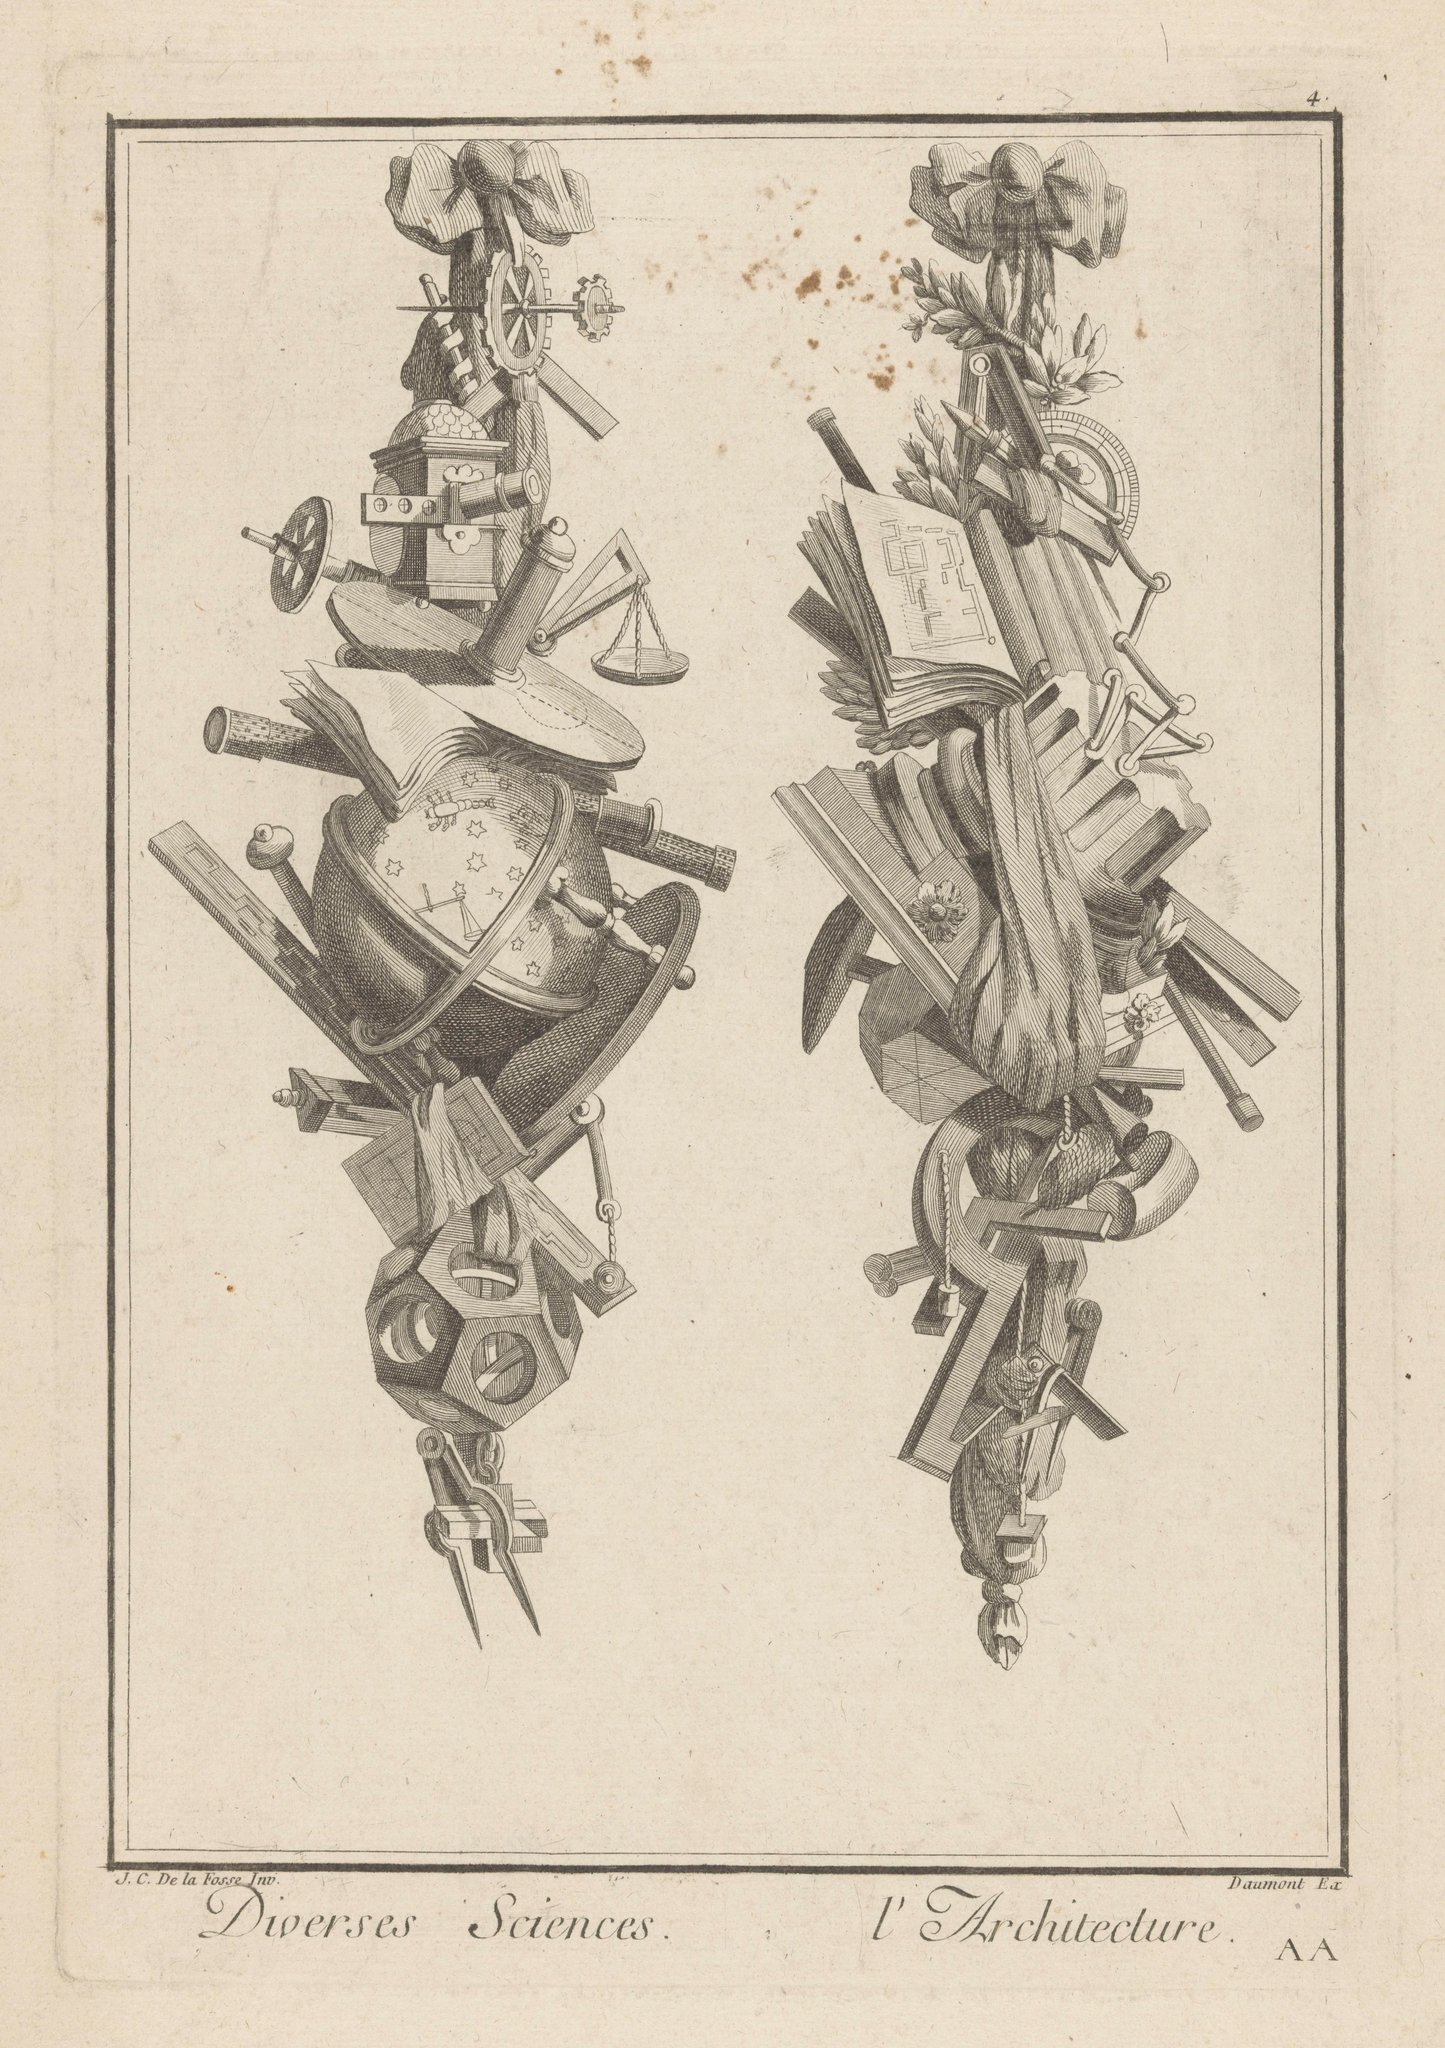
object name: ornament print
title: Diverses Sciences, l'Architecture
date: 1745-1755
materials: paper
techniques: engraving, etching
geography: paris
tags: trophy, i.e.: decorative arrangement of symbolic or typical objects ~ ornament, symbolic representations, allegories and emblems ~ science, 'scientia'; 'scienza', 'studio' (ripa), 'architectura', symbolic representations, allegories and emblems ~ architecture; 'architettura' (ripa)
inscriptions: collector's mark: Lugt 2760, collector's mark: Lugt 2228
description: Links een trofee met attributen behorende bij diverse wetenschappen zoals een globe, telescopen en meetinstrumenten. Rechts een trofee met attributen behorende bij architectuur zoals een plattegrond, een basement en meetinstrumenten.